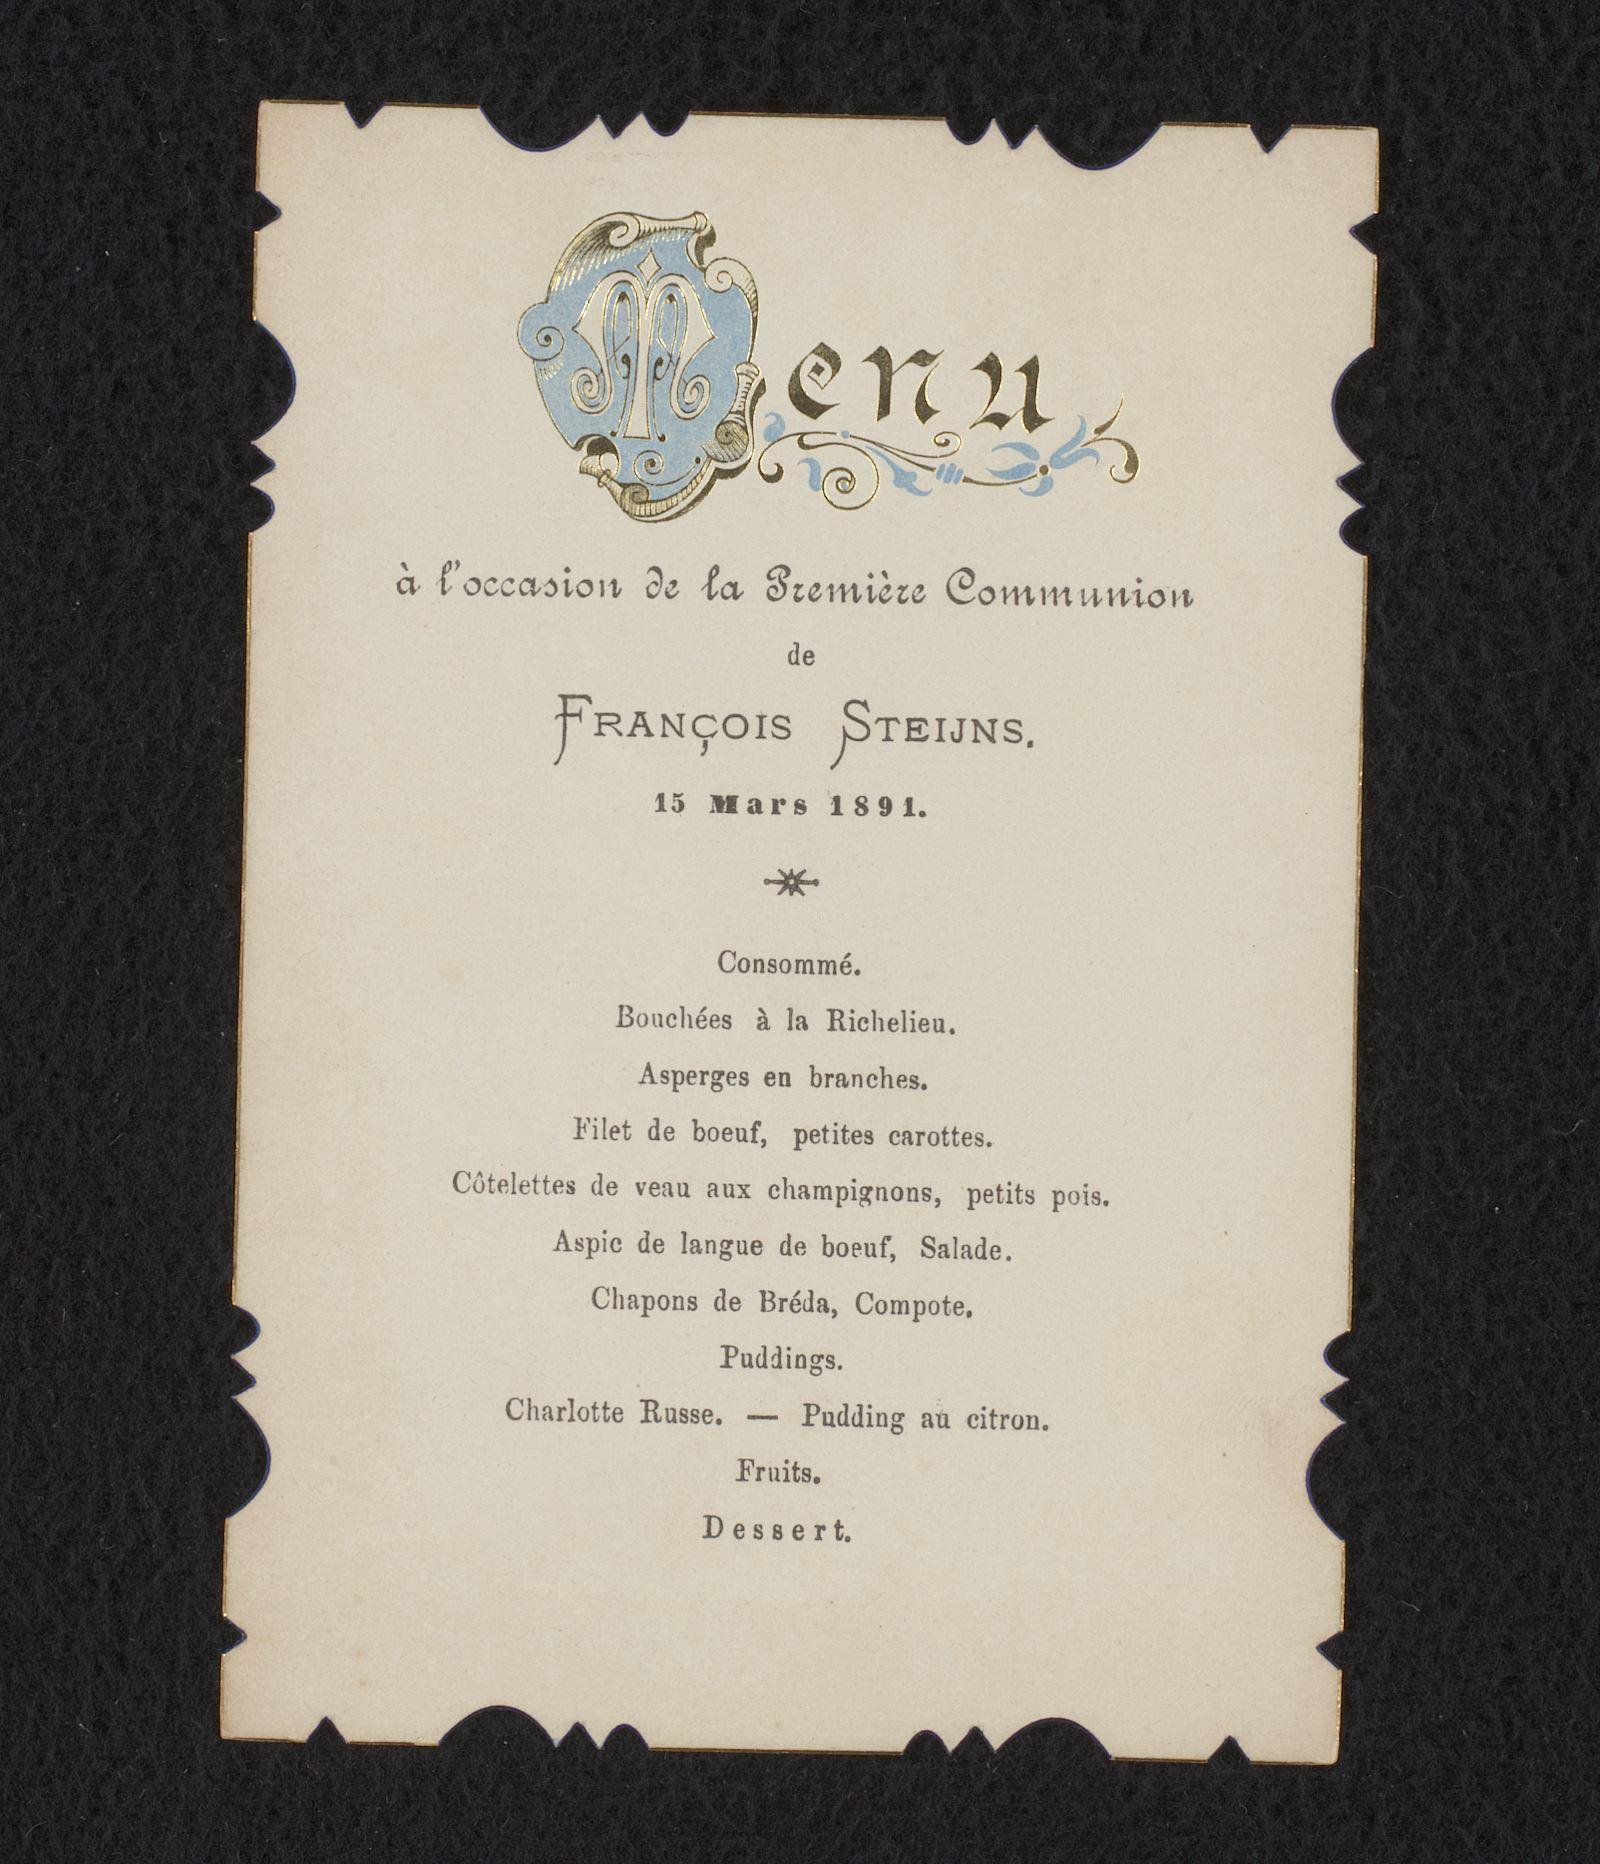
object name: menu, menukaart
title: Menu van het diner ter ere van de eerste heilige communie van François Steijns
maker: Anonymous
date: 1891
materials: paper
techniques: blind stamped, printing block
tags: first communion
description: Bij gebrek aan gegevens over de vervaardiger is voor de bepaling van de rechten van dit object gebruik gemaakt van de vervaardigingsdatum.